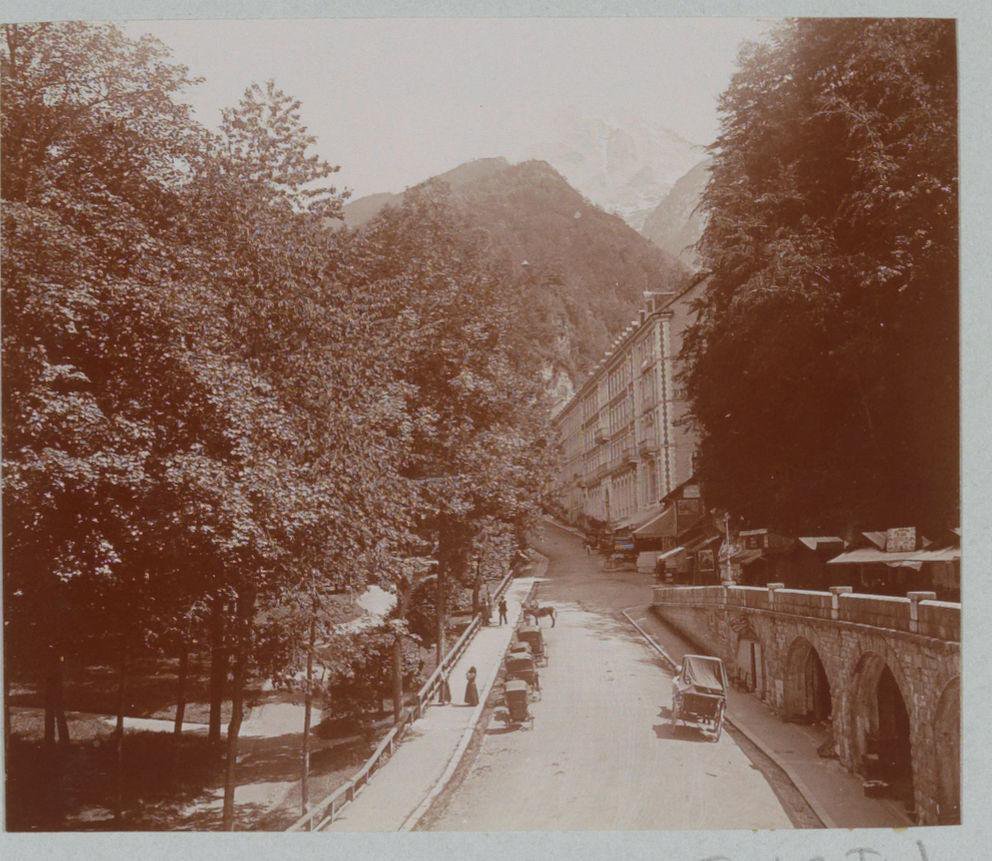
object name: photograph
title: Hellende straat met koetsen, voorbijgangers en gebouwen, vermoedelijk in Frankrijk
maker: Anonymous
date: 1905-1910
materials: paper, photographic support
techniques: gelatin silver print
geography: france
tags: animal traction, animal-drawn vehicle (carriage etc.), sloping street; street with steps or stairs, mountains (+ landscape with figures, staffage), exterior ~ representation of a building, france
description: Onderdeel van Fotoalbum van een Franse amateurfotograaf met bezienswaardigheden in Frankrijk, Zwitserland en Italië.